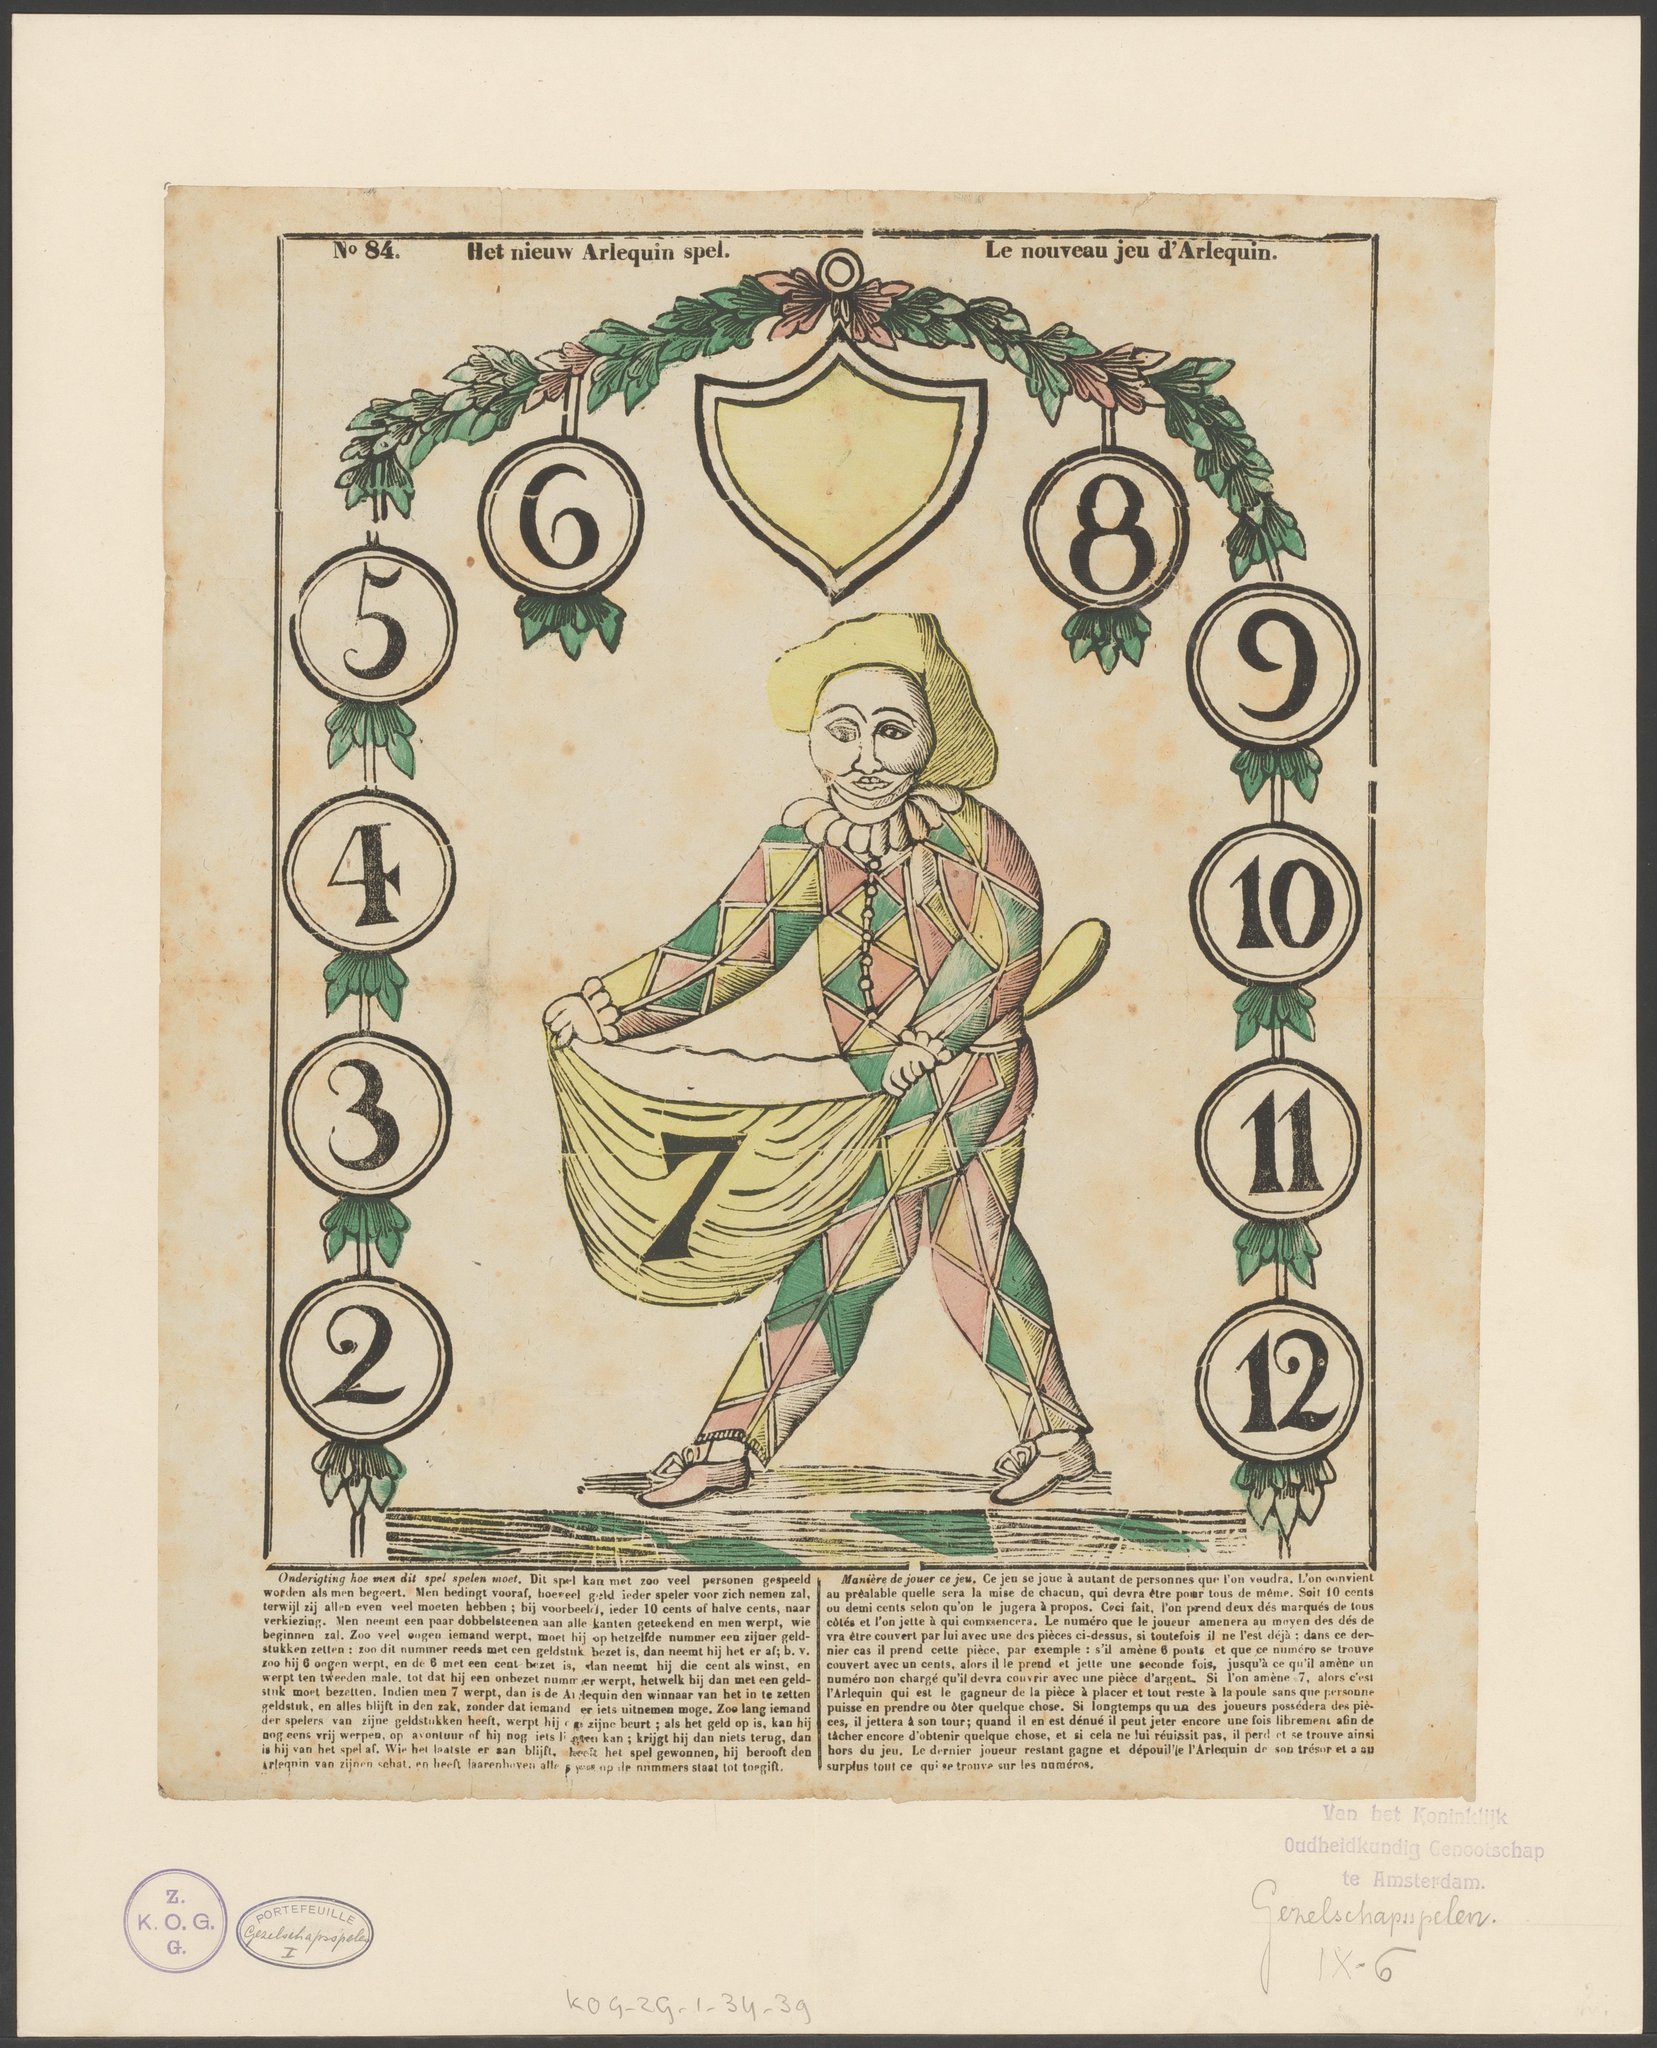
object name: gameboard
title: Het nieuw Arlequin spel. Le nouveau jeu d'Arlequin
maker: Anonymous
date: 1850-1899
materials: paper, watercolor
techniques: hand coloring, letterpress printing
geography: turnhout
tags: board-games of chance, types in 'commedia dell'arte': harlequin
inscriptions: collector's mark, collector's mark: Lugt 1641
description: Bordspel met in het midden van het speelveld een harlekijn die in zijn handen een zak houdt met daarop het cijfer 7. Rondom hem een guirlande waaraan medaillons hangen met de cijfers 2 tot en met 12. Bovenaan in het midden een schild. Onder de voorstelling de spelregels in het Nederlands en in het Frans in twee kolommen. Genummerd linksboven: No 84. Onderwerpsrubrieken binnen de Atlas Zeden en Gewoonten: Spel en Vermaak; gezelschapsspel, ganzenbord en dergelijke.